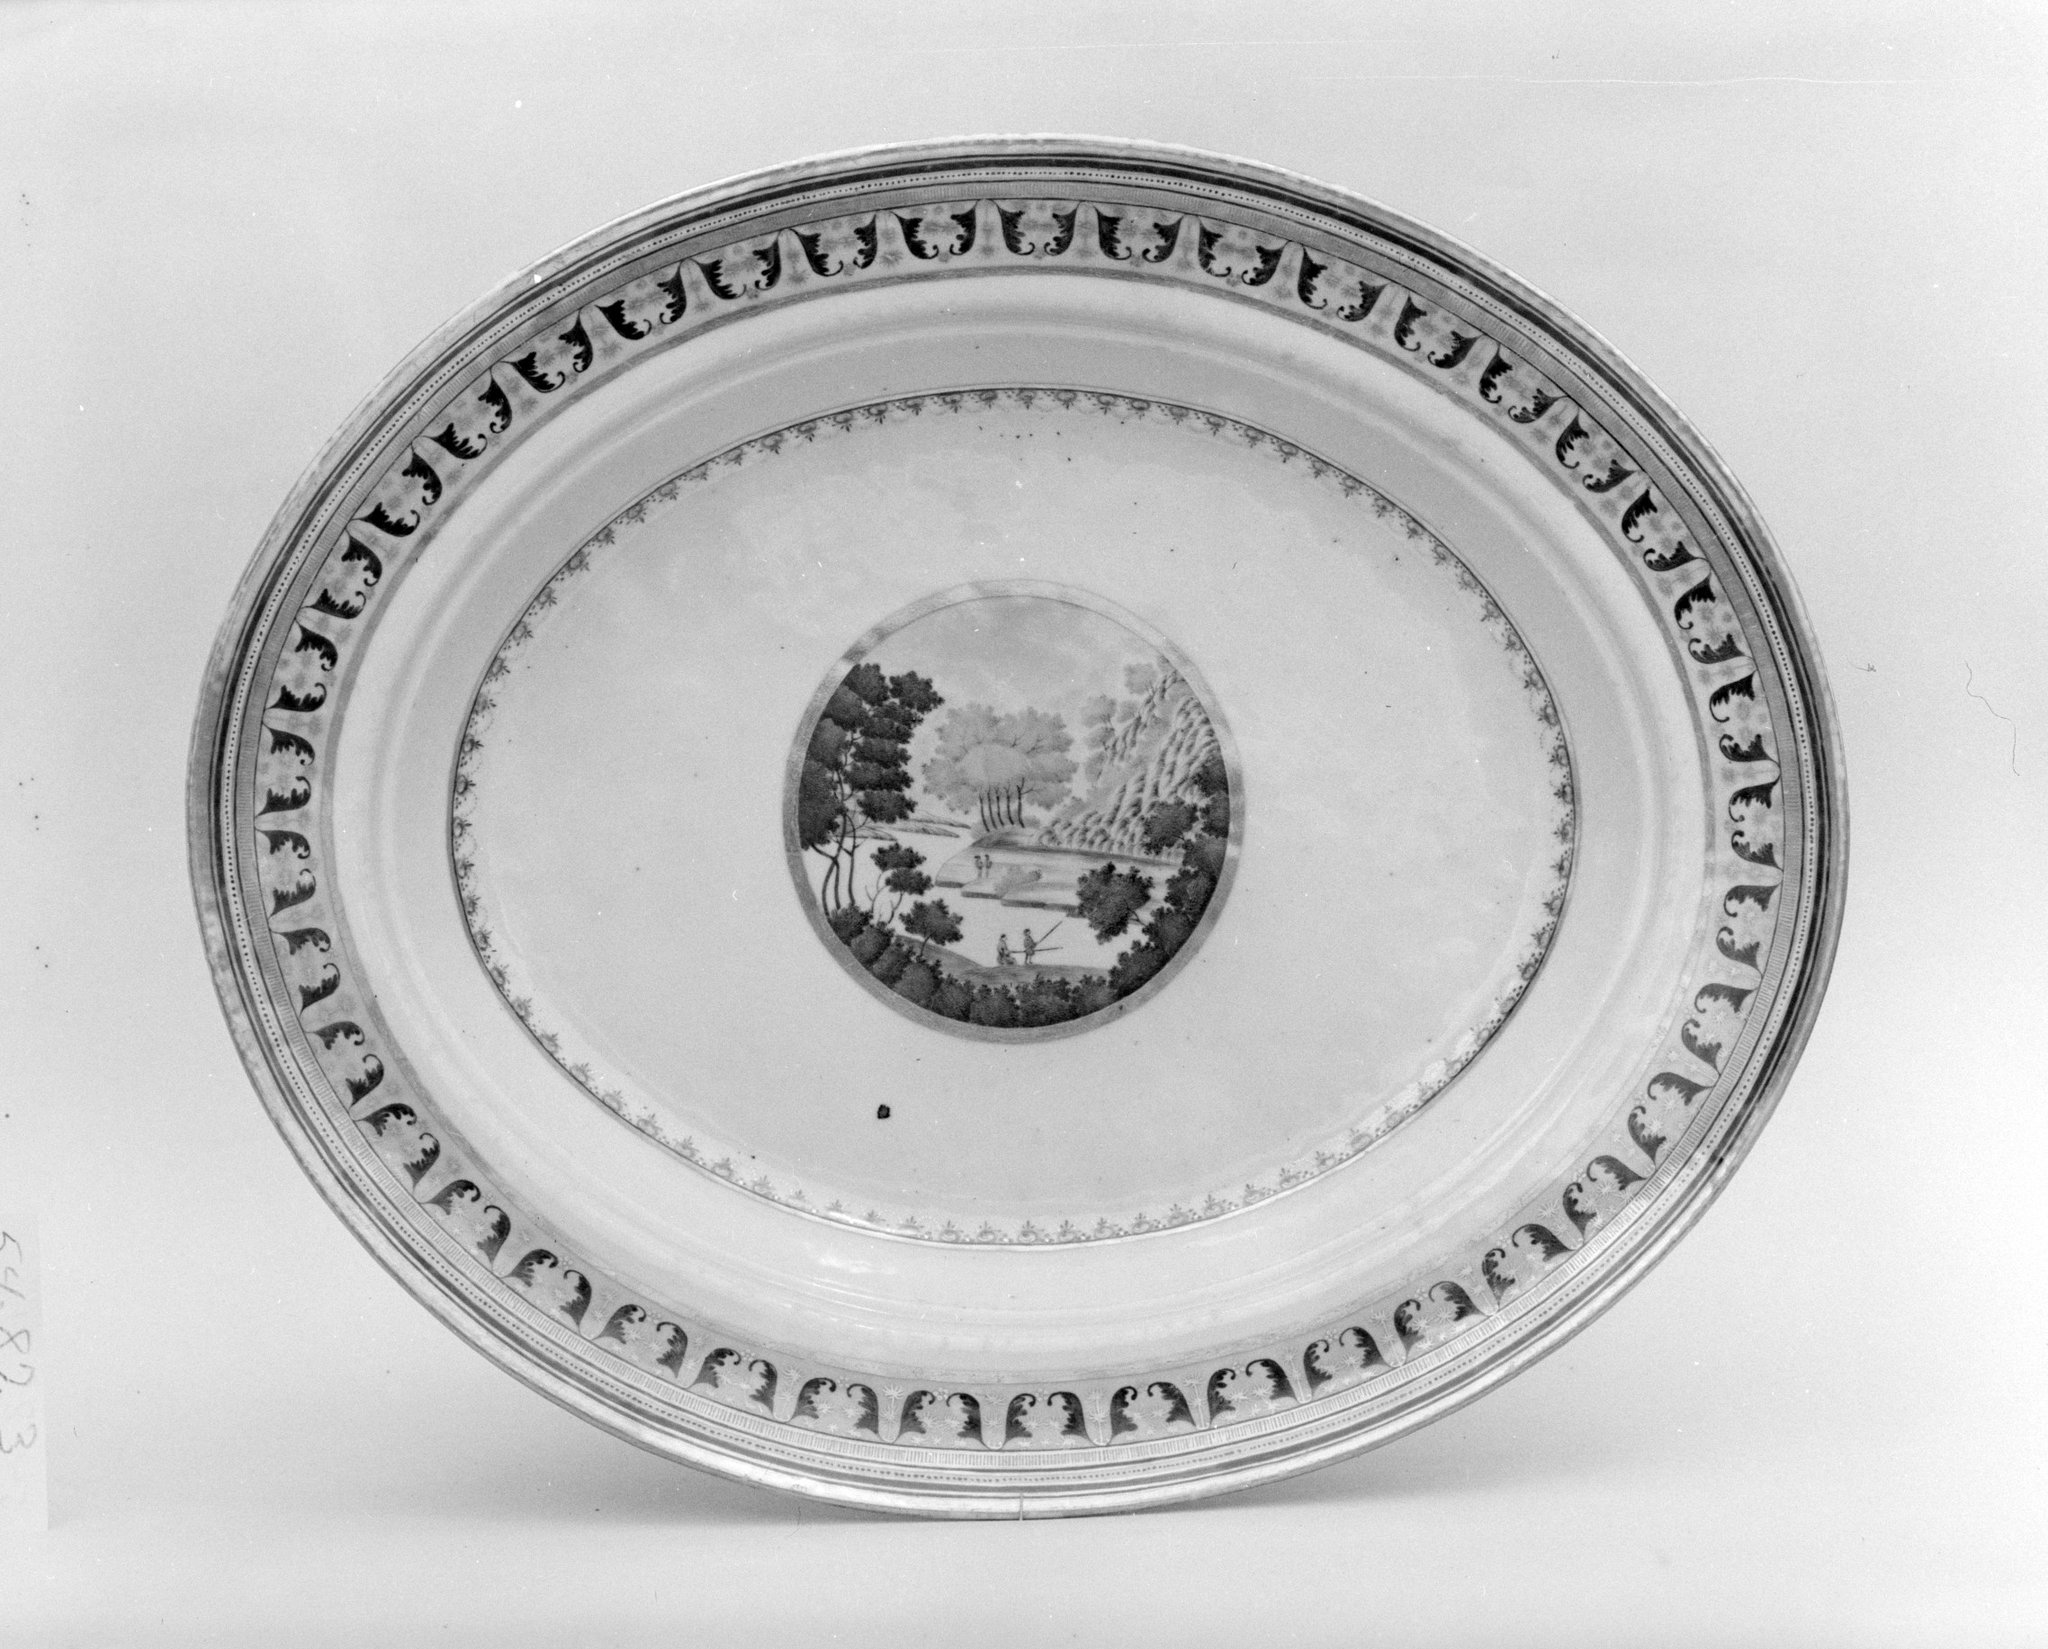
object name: platter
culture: chinese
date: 1800-1830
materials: porcelain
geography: china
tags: landscapes